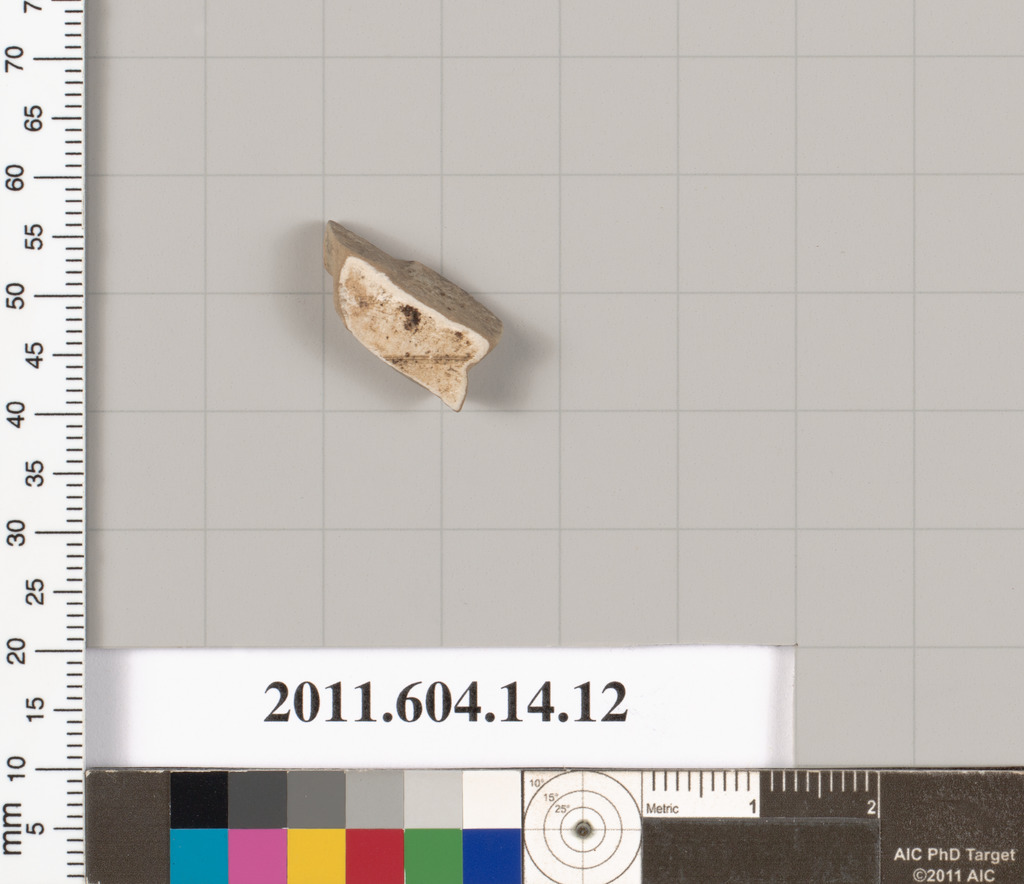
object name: undetermined closed shape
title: Terracotta fragment of a closed shape?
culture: unknown fabric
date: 600-501 BCE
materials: terracotta